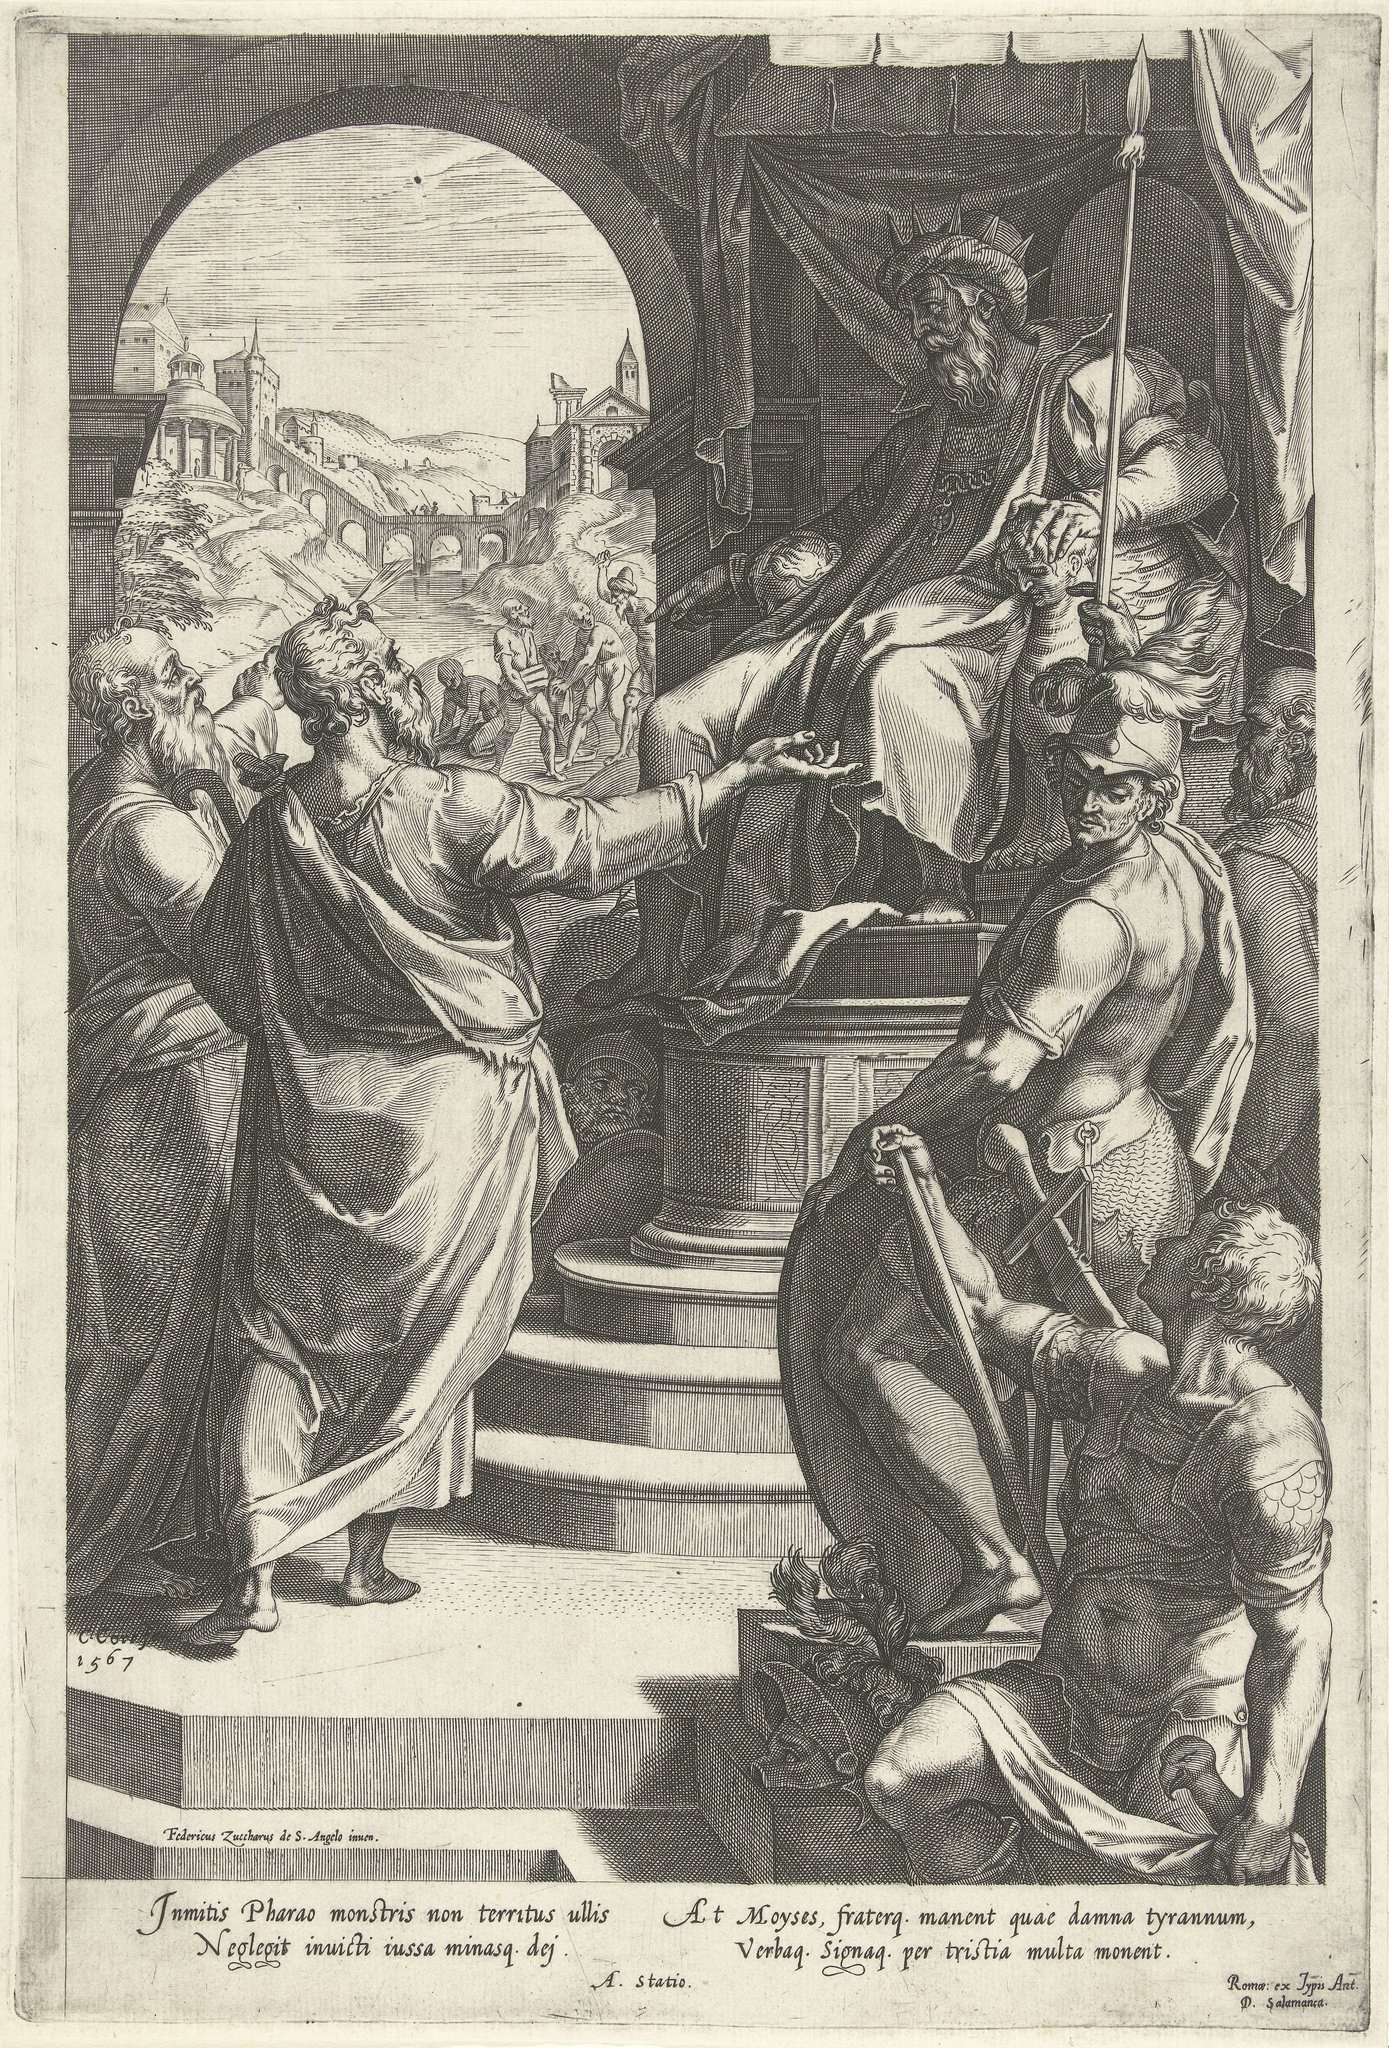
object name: print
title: Mozes en Aaron voor de farao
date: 1567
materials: paper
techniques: engraving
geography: rome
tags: moses and aaron confront pharaoh (exodus 5-7:13)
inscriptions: collector's mark: Lugt 240, signature: ‘A. Statio’, date: ‘1567’, caption: ‘Inmittis Pharao monstris non territus ullis / Neglegit invicti iussa minasq. dej. // At Moyses, fraterq. manent quae damna tyrannum, / Verbaq. Signaq. per tristia multa monent.’, signature: ‘C. Cort fe.’, signature: ‘Federicis Zuccharus de S. Angelo inven.’, address: ‘Romae: ex typis Ant. / D. Salamanca’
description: De farao zit op een hoge troon onder een baldakijn. Naast hem staan soldaten. Mozes en Aaron staan voor hem. Door een boogvormige nis is de stad te zien. Voor het palast van de farao wacht een groepje mensen.